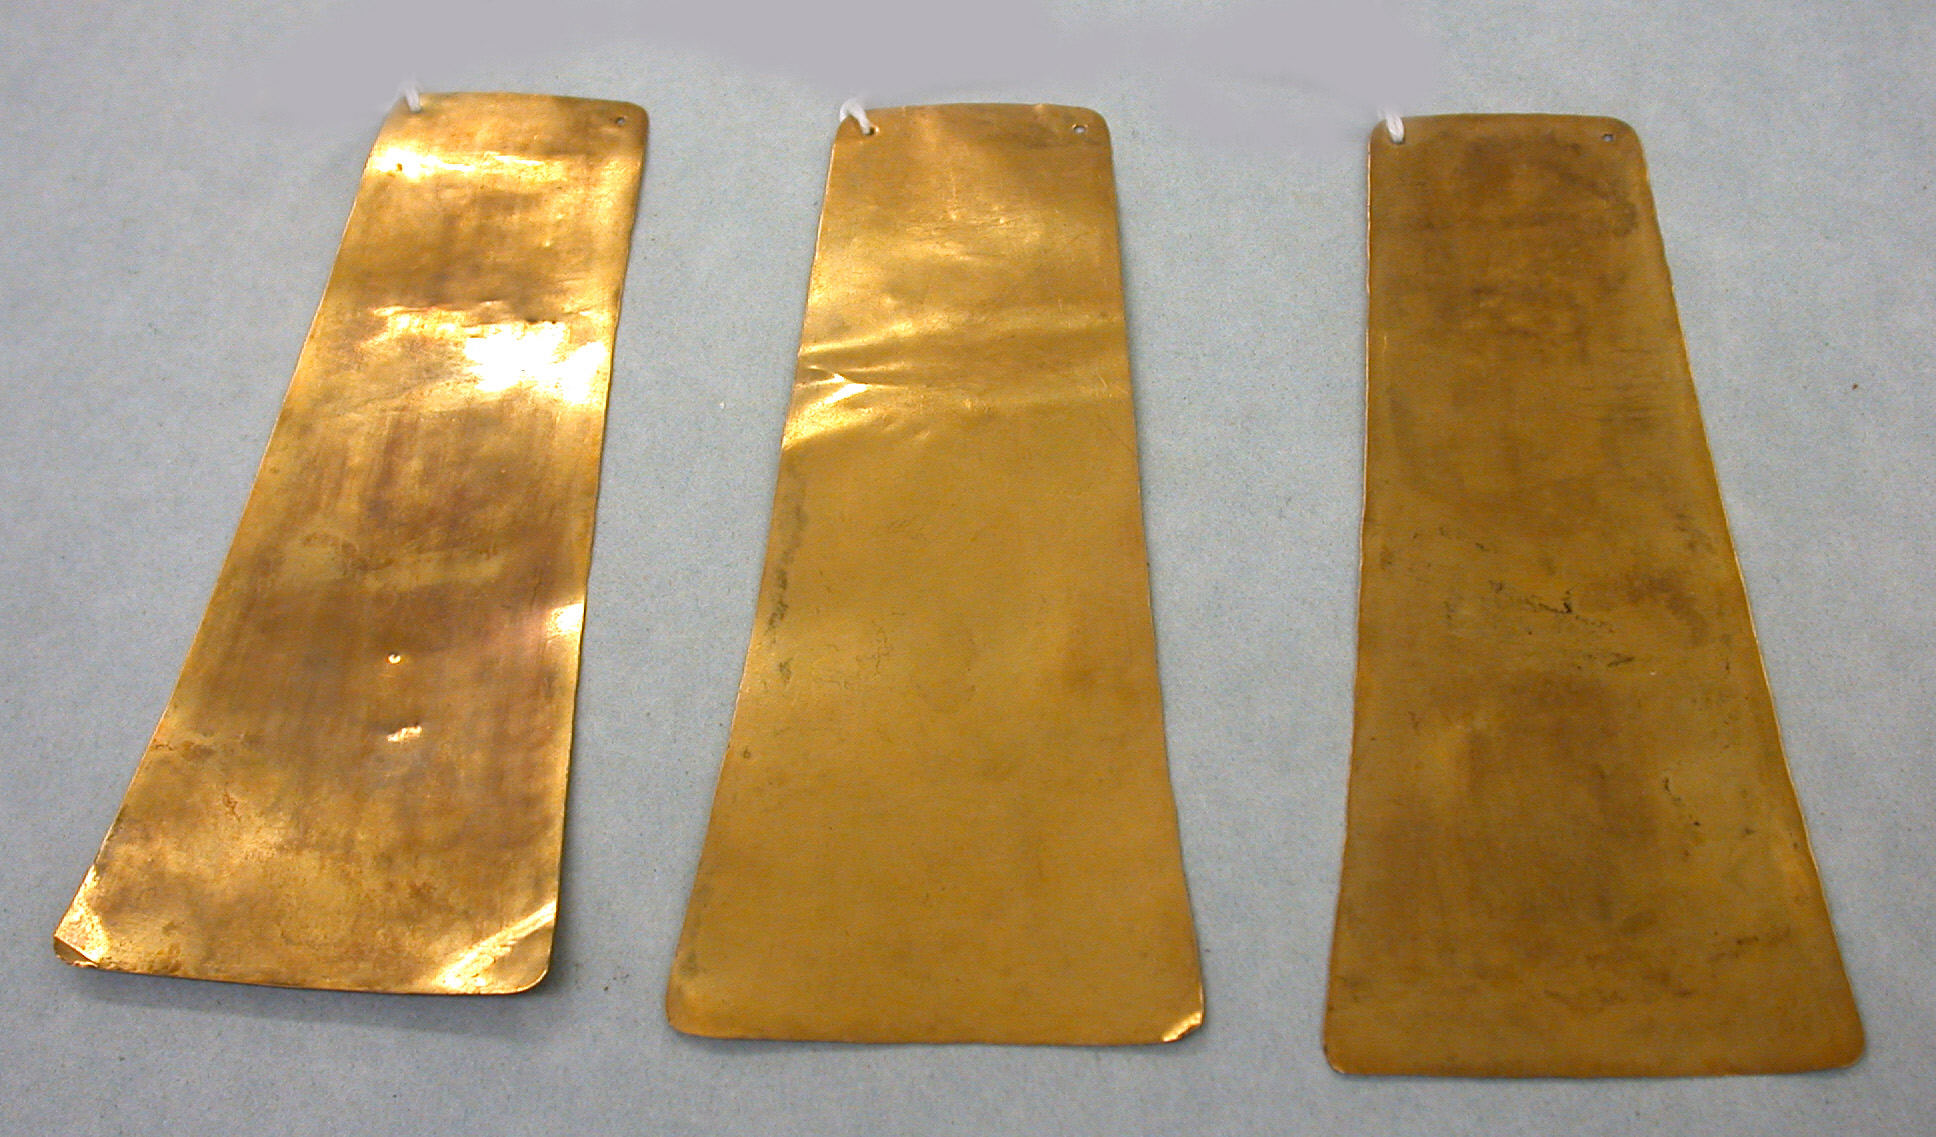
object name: ornament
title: Tab Ornament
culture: salinar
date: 100 BCE-200 CE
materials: gold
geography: peru